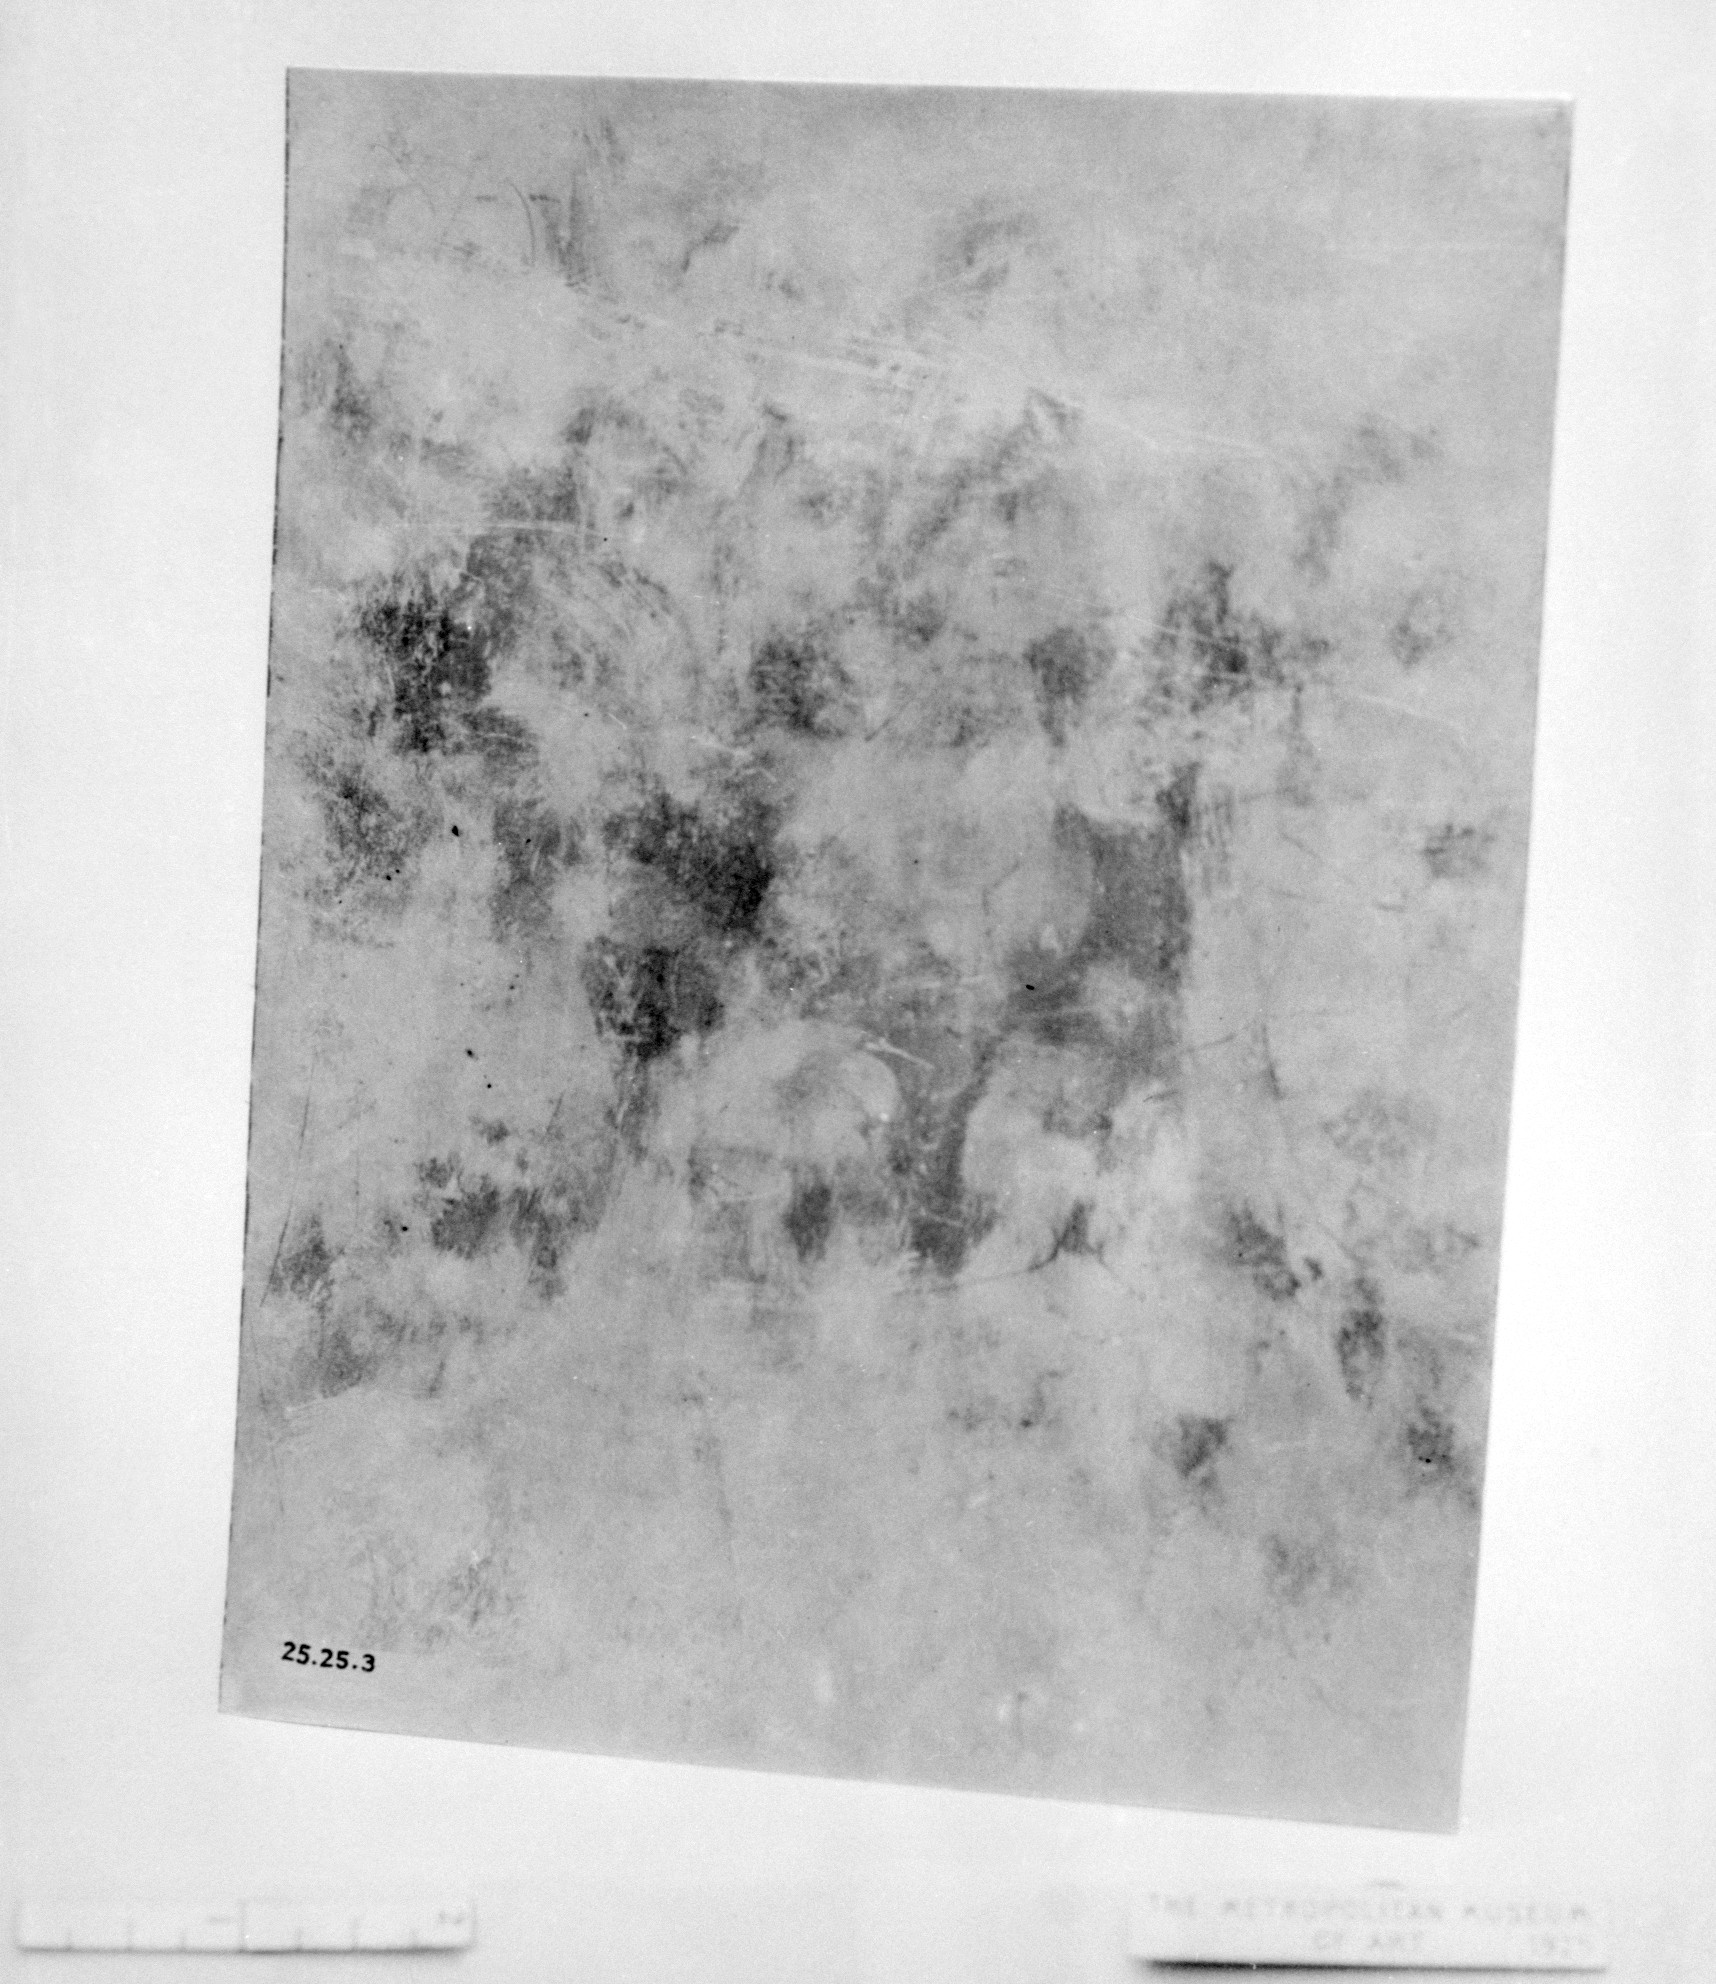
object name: sheet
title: Metal sheet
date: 1801-1900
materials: metal